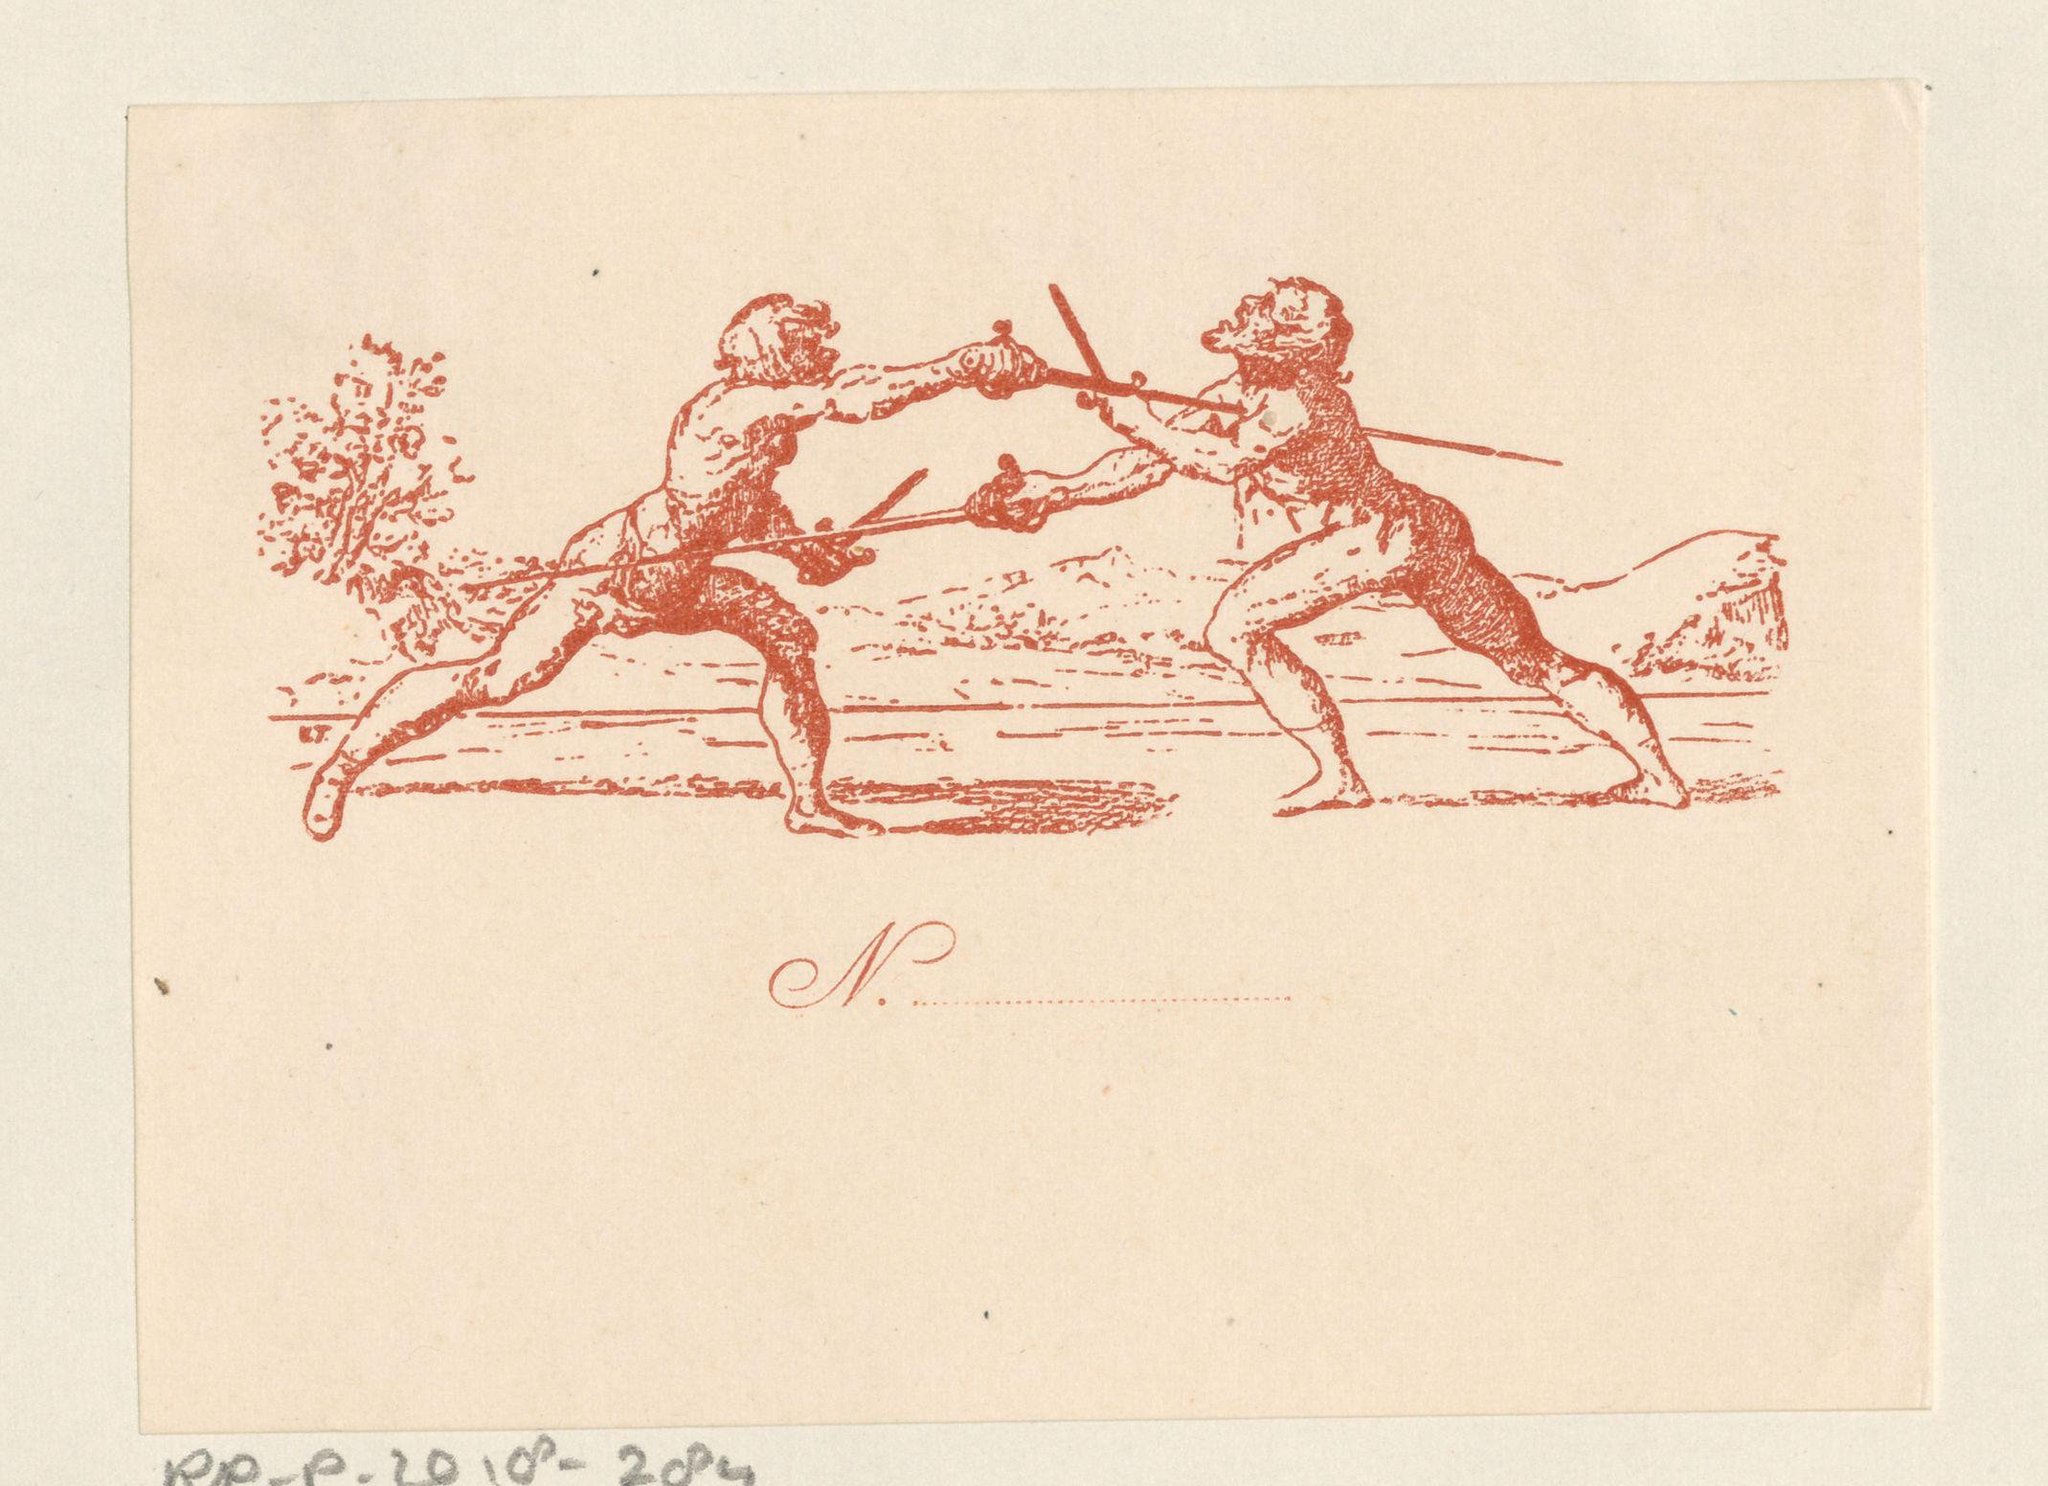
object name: bookplate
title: Ex libris, mogelijk van Jacopo Gelli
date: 1868-1935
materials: paper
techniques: printing block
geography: italy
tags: sabre (~ fencing), hacking and thrusting weapons (with name), man (showing himself) undressed, quasi-nude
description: Het verzamelaarsmerk behoort toe aan Sir A.W. Franks (1826-1897), conservator bij het British Museum en verzamelaar van o.a. ex libris. In 1921 werd een deel van zijn collectie in Londen geveild.